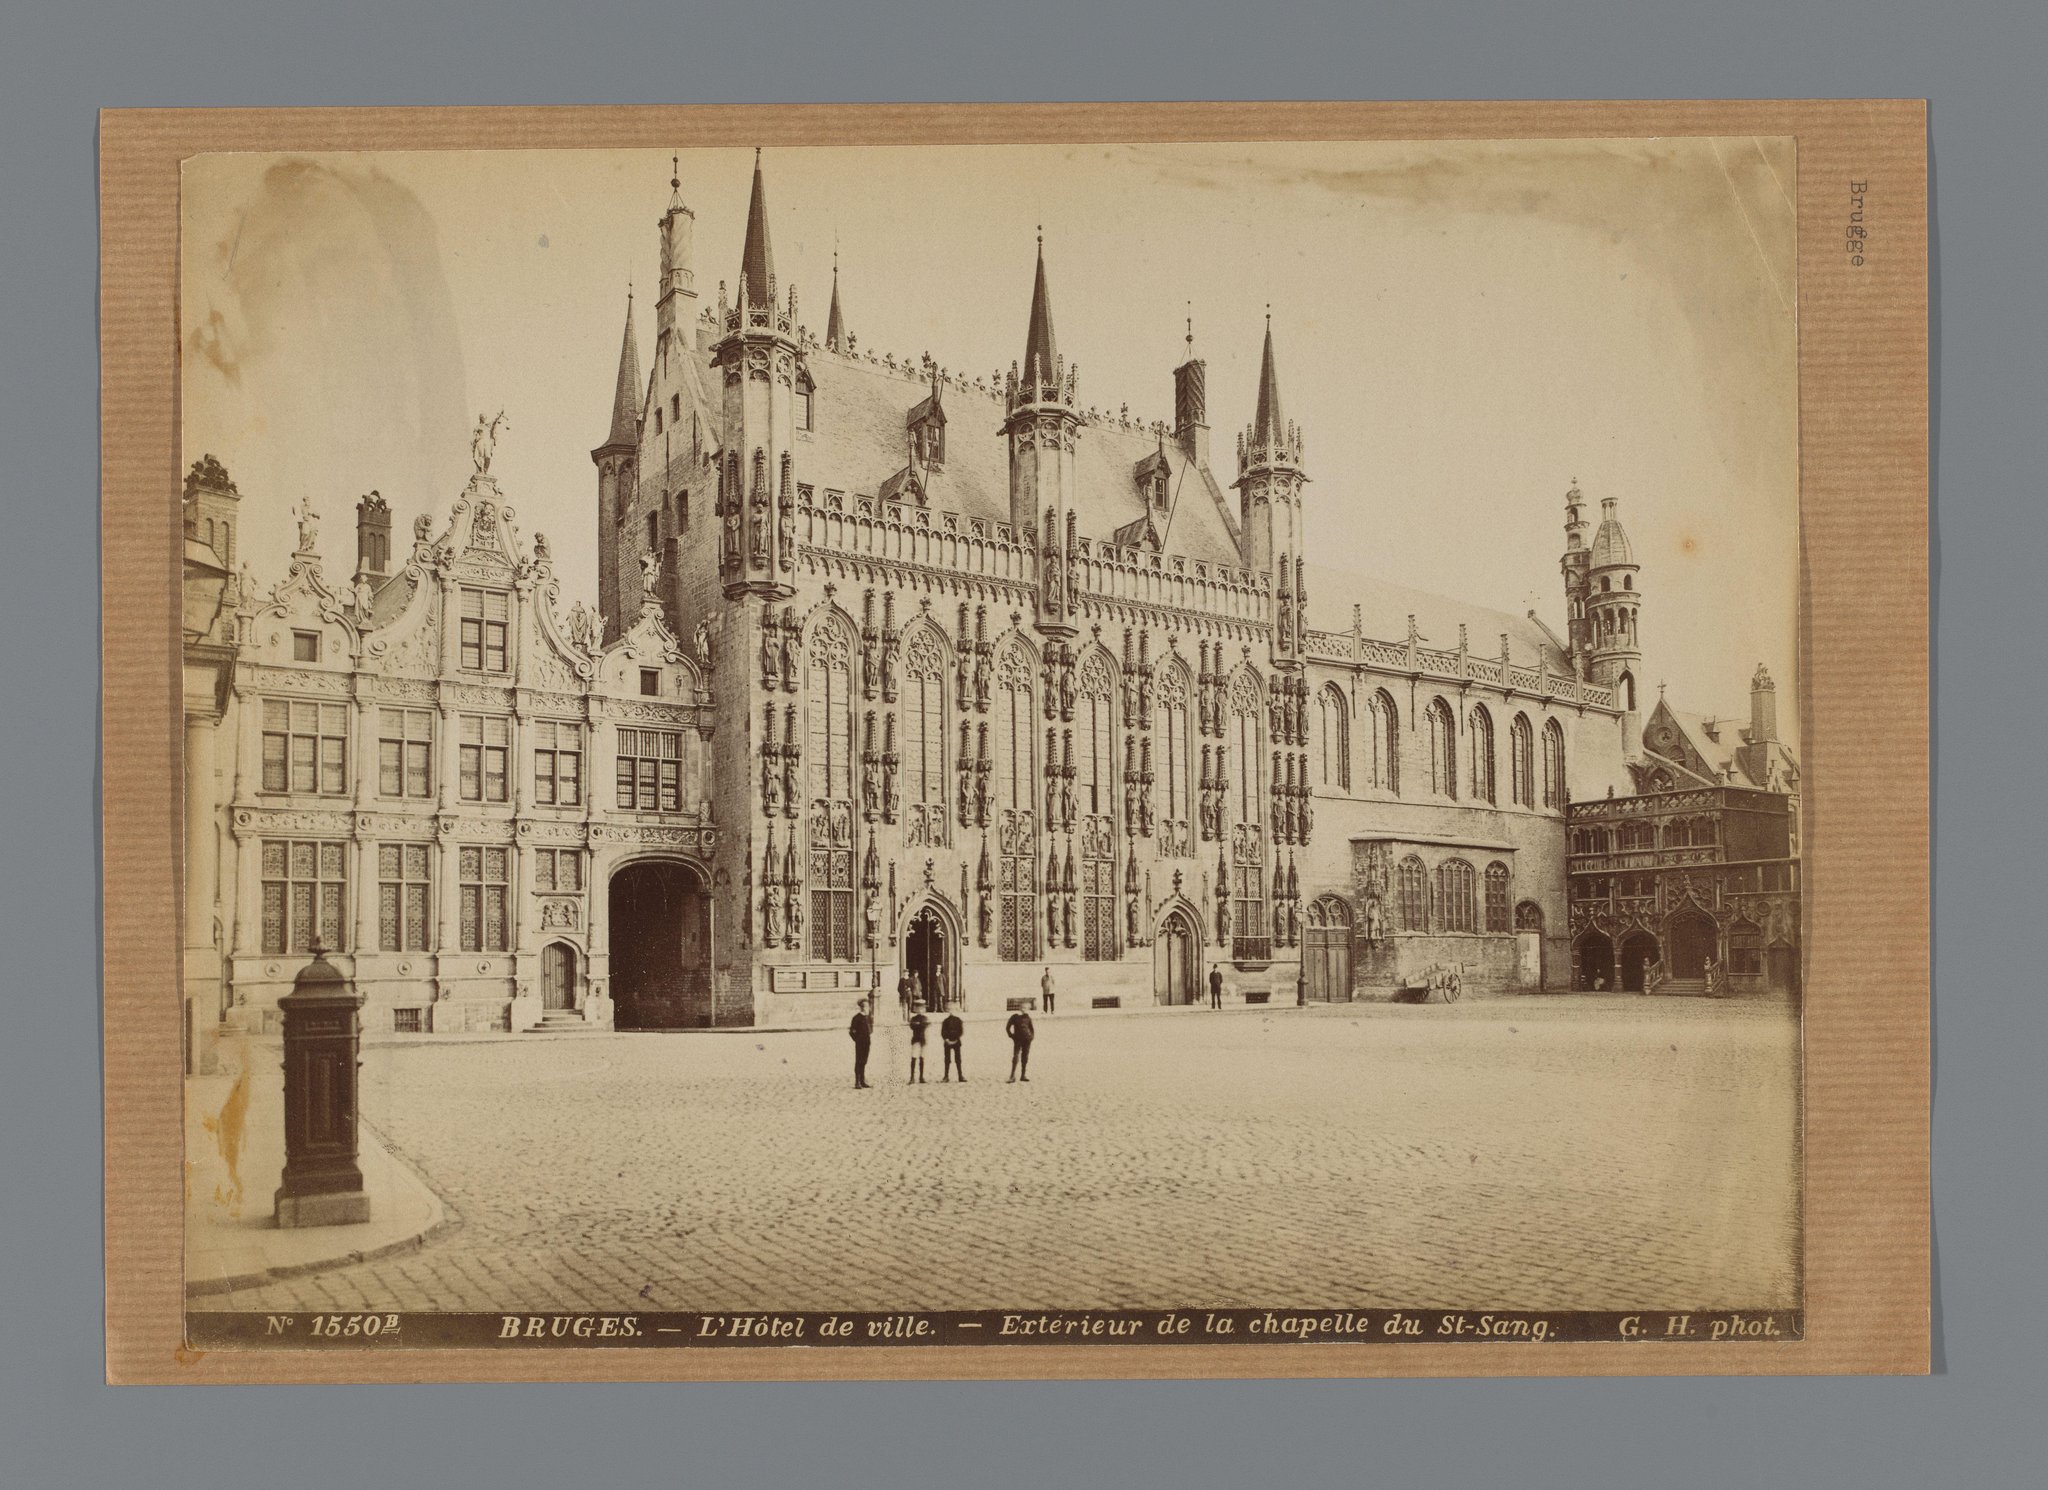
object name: photograph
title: Brugge. L'Hotel de ville. Chapelle du St-Sang. Vrije.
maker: Anonymous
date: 1850-1900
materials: photographic support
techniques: albumen print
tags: bruges